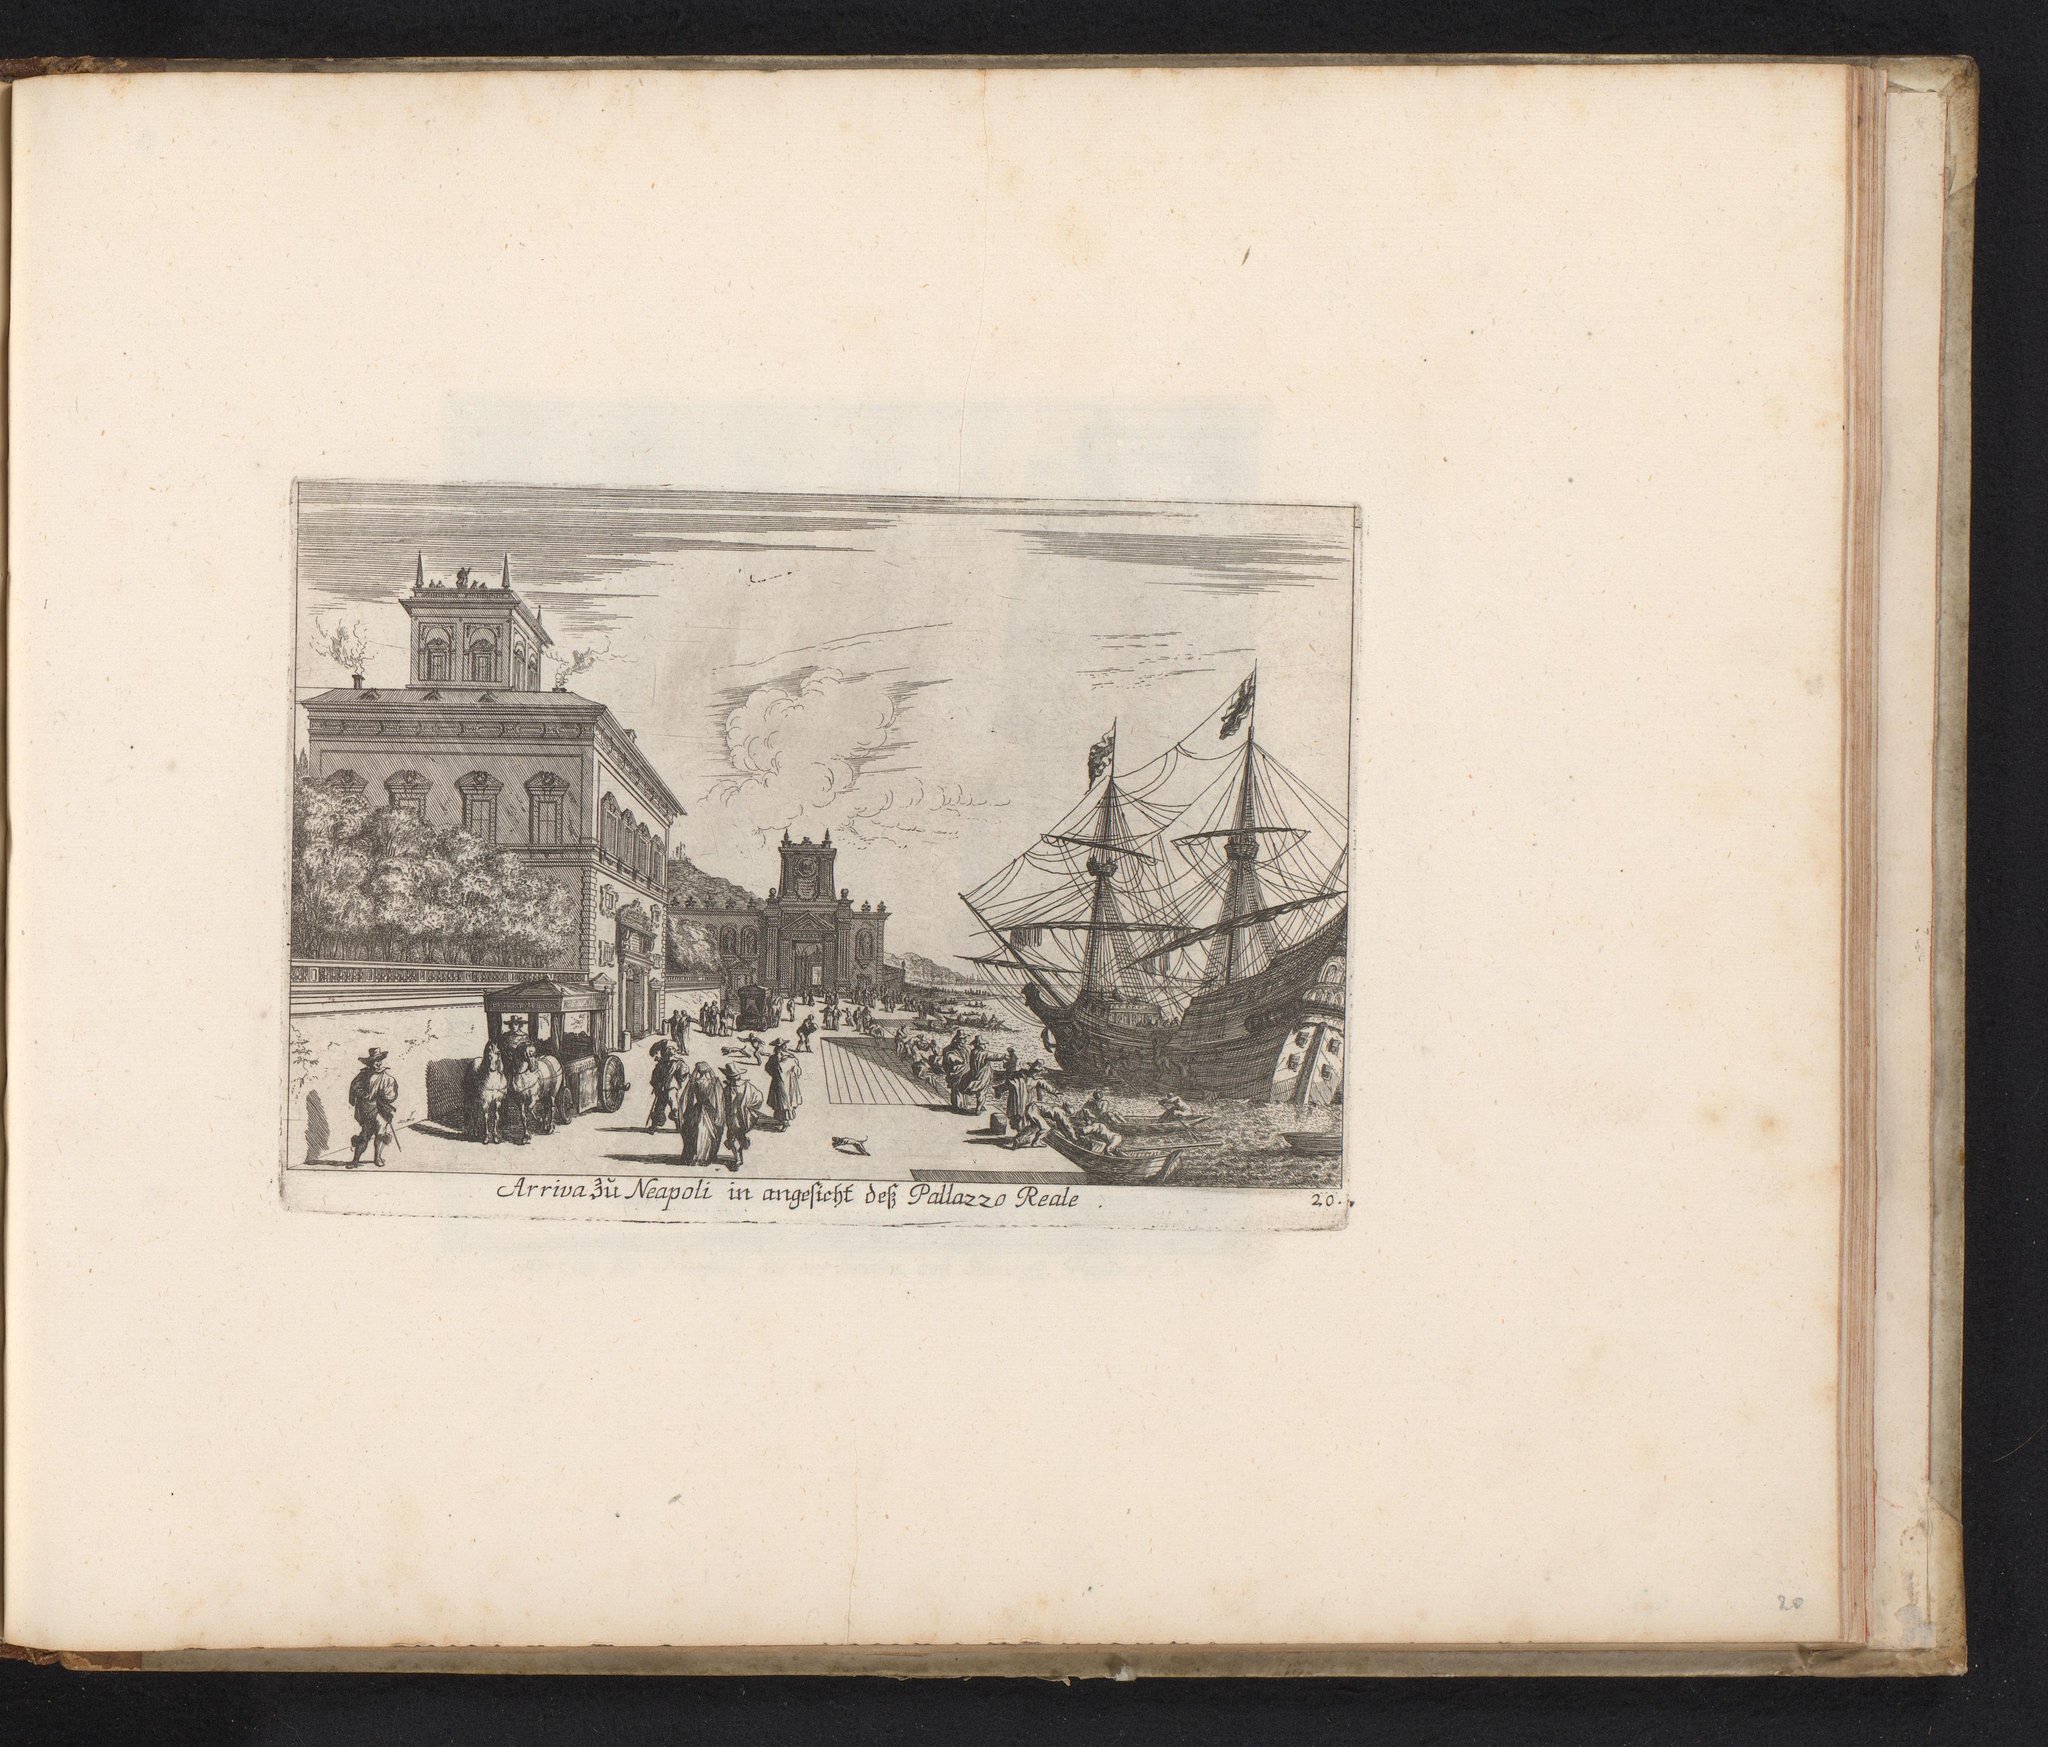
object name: album leaf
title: Werf bij het koninklijk paleis in Napels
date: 1670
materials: paper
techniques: etching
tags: pier, quay, wharf (+ four persons or more ~ traffic and transport), palace, naples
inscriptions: collector's mark: Lugt 2228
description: Tekst in het Duits in de ondermarge. Rechtsonder genummerd: 20. Prent maakt deel uit van een album.